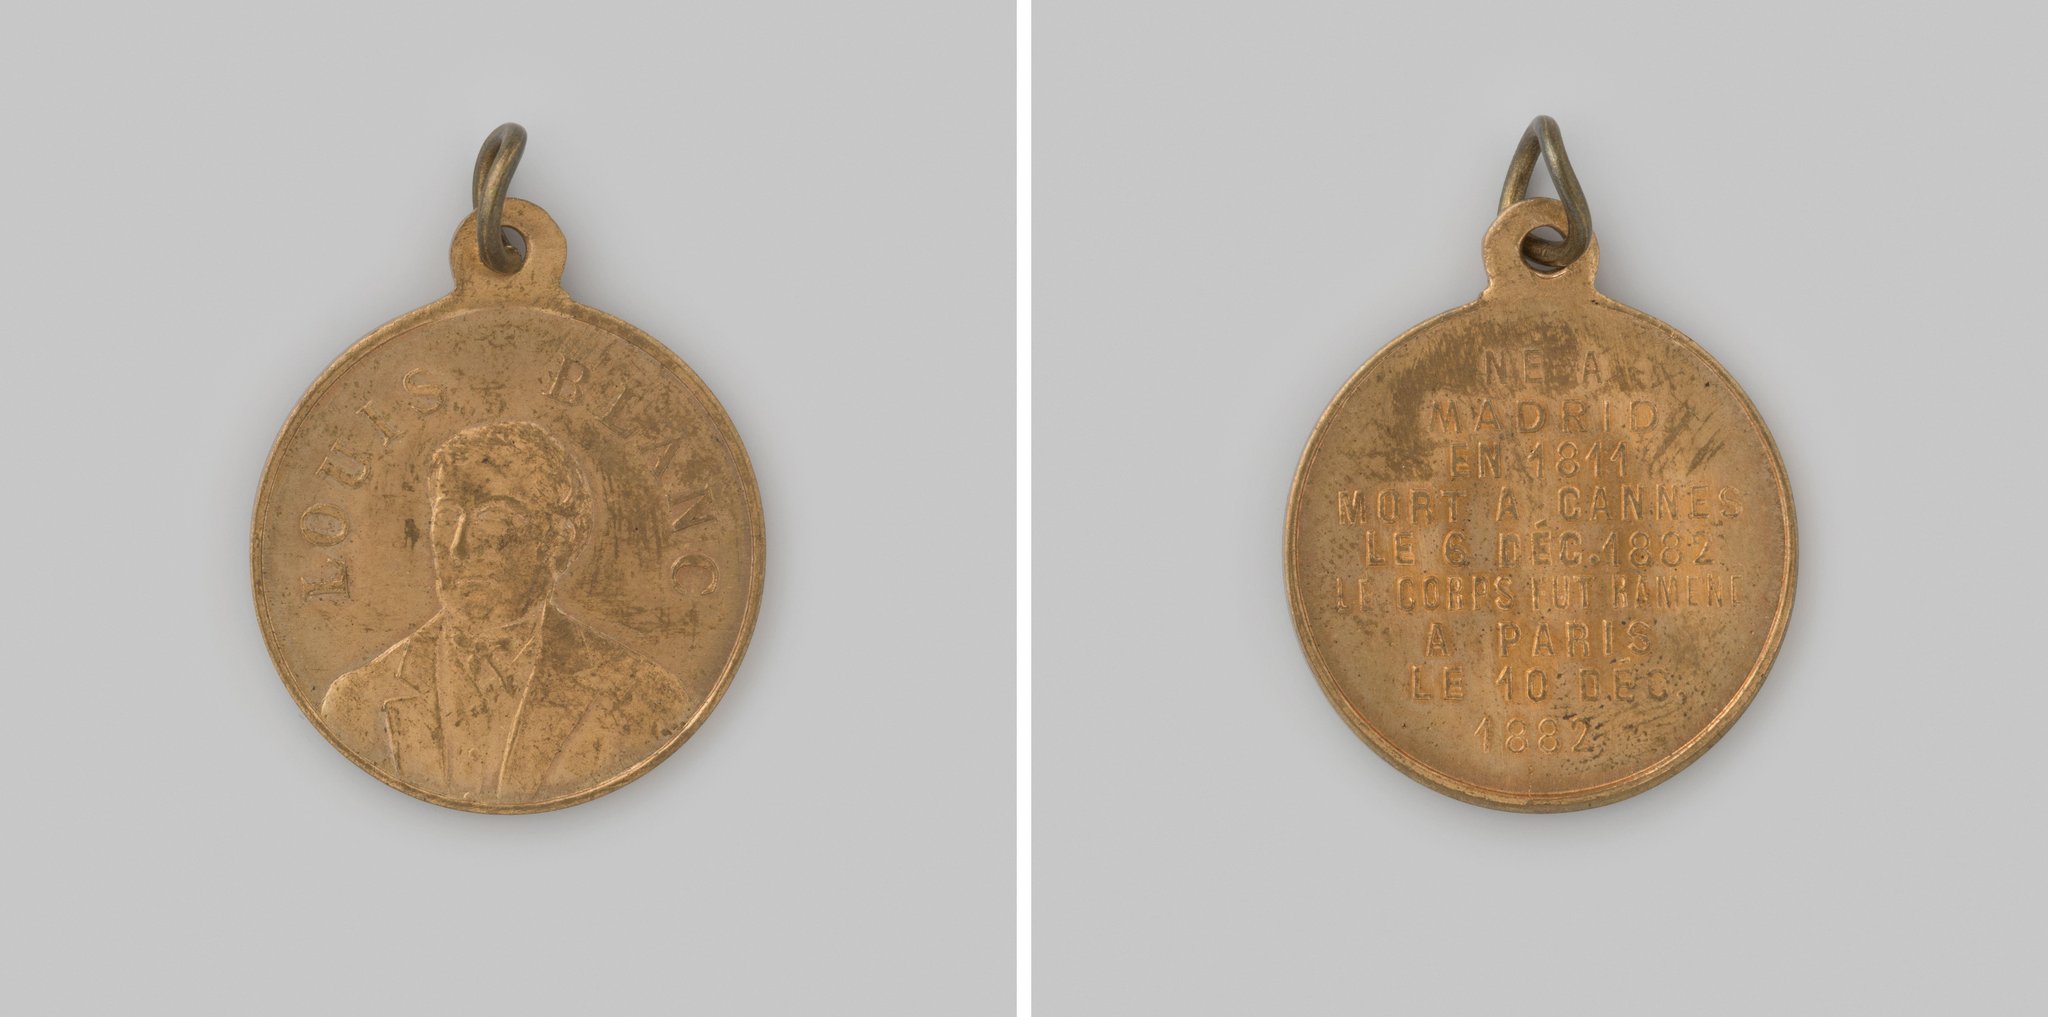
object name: history medal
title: Louis Blanc 1811-1882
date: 1882-1900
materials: brass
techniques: striking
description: Vergulde penning met oog en draagring, op de voorzijde het aanziende borstbeeld van Blanc, het hoofd naar links, met omschrift, op de keerzijde negen regels tekst.